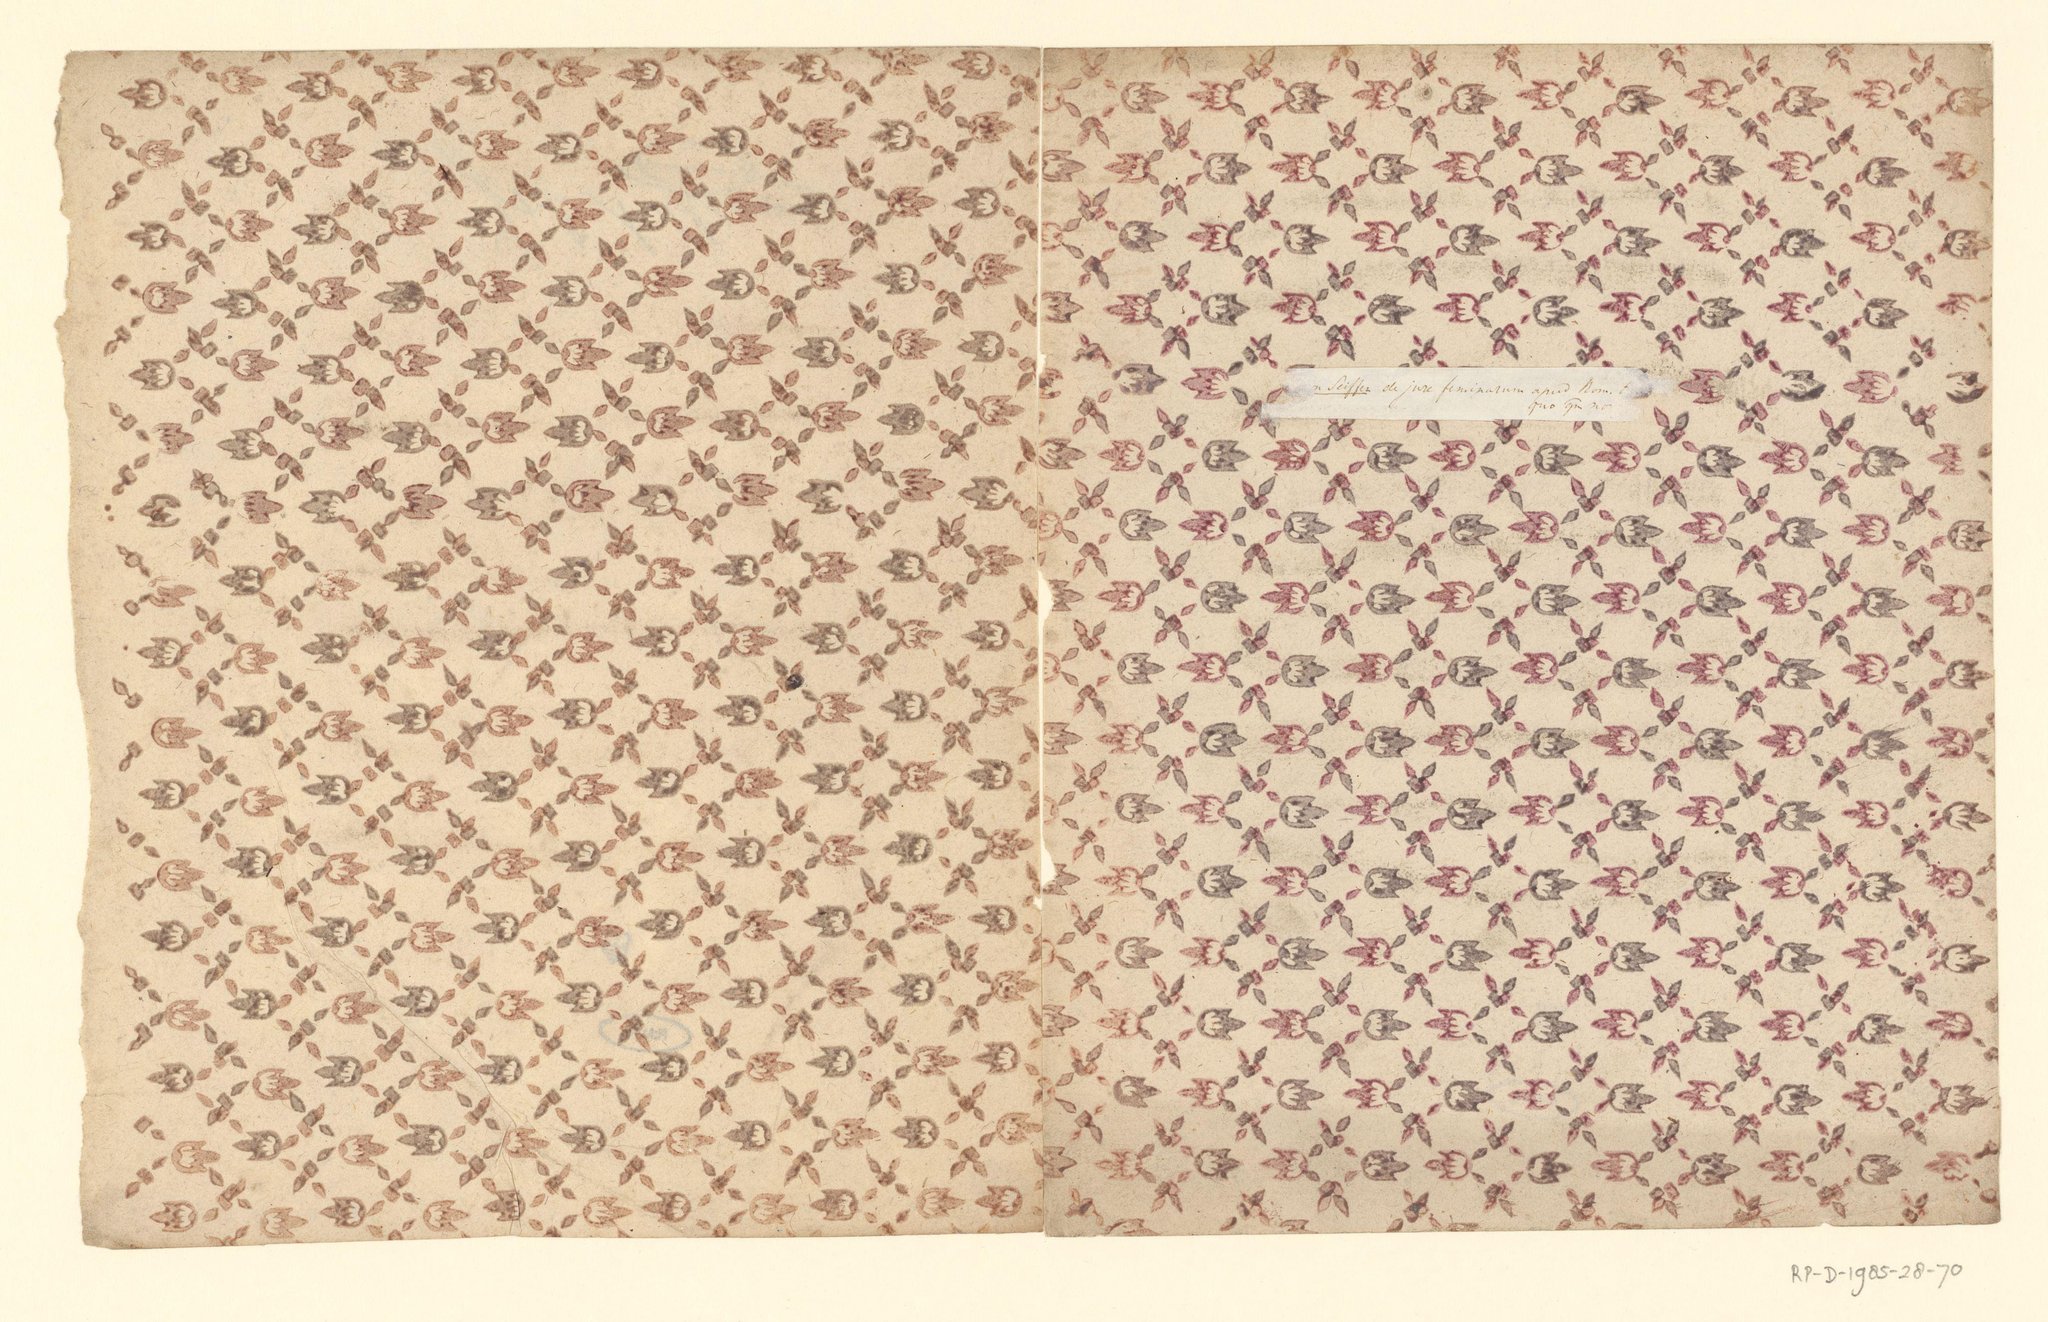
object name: wrapper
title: Twee bladen met ruitenpatroon van bladmotief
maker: Anonymous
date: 1750-1900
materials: paper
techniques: printing block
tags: ornament derived from plant forms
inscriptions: collector's mark: Lugt 2228, collector's mark: Lugt 2760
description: Twee bladen met ruitenpatroon van bladmotief. Met etiket met opschrift: 'Seiffer ... quo ... .' Twee losse helften van een omslag.